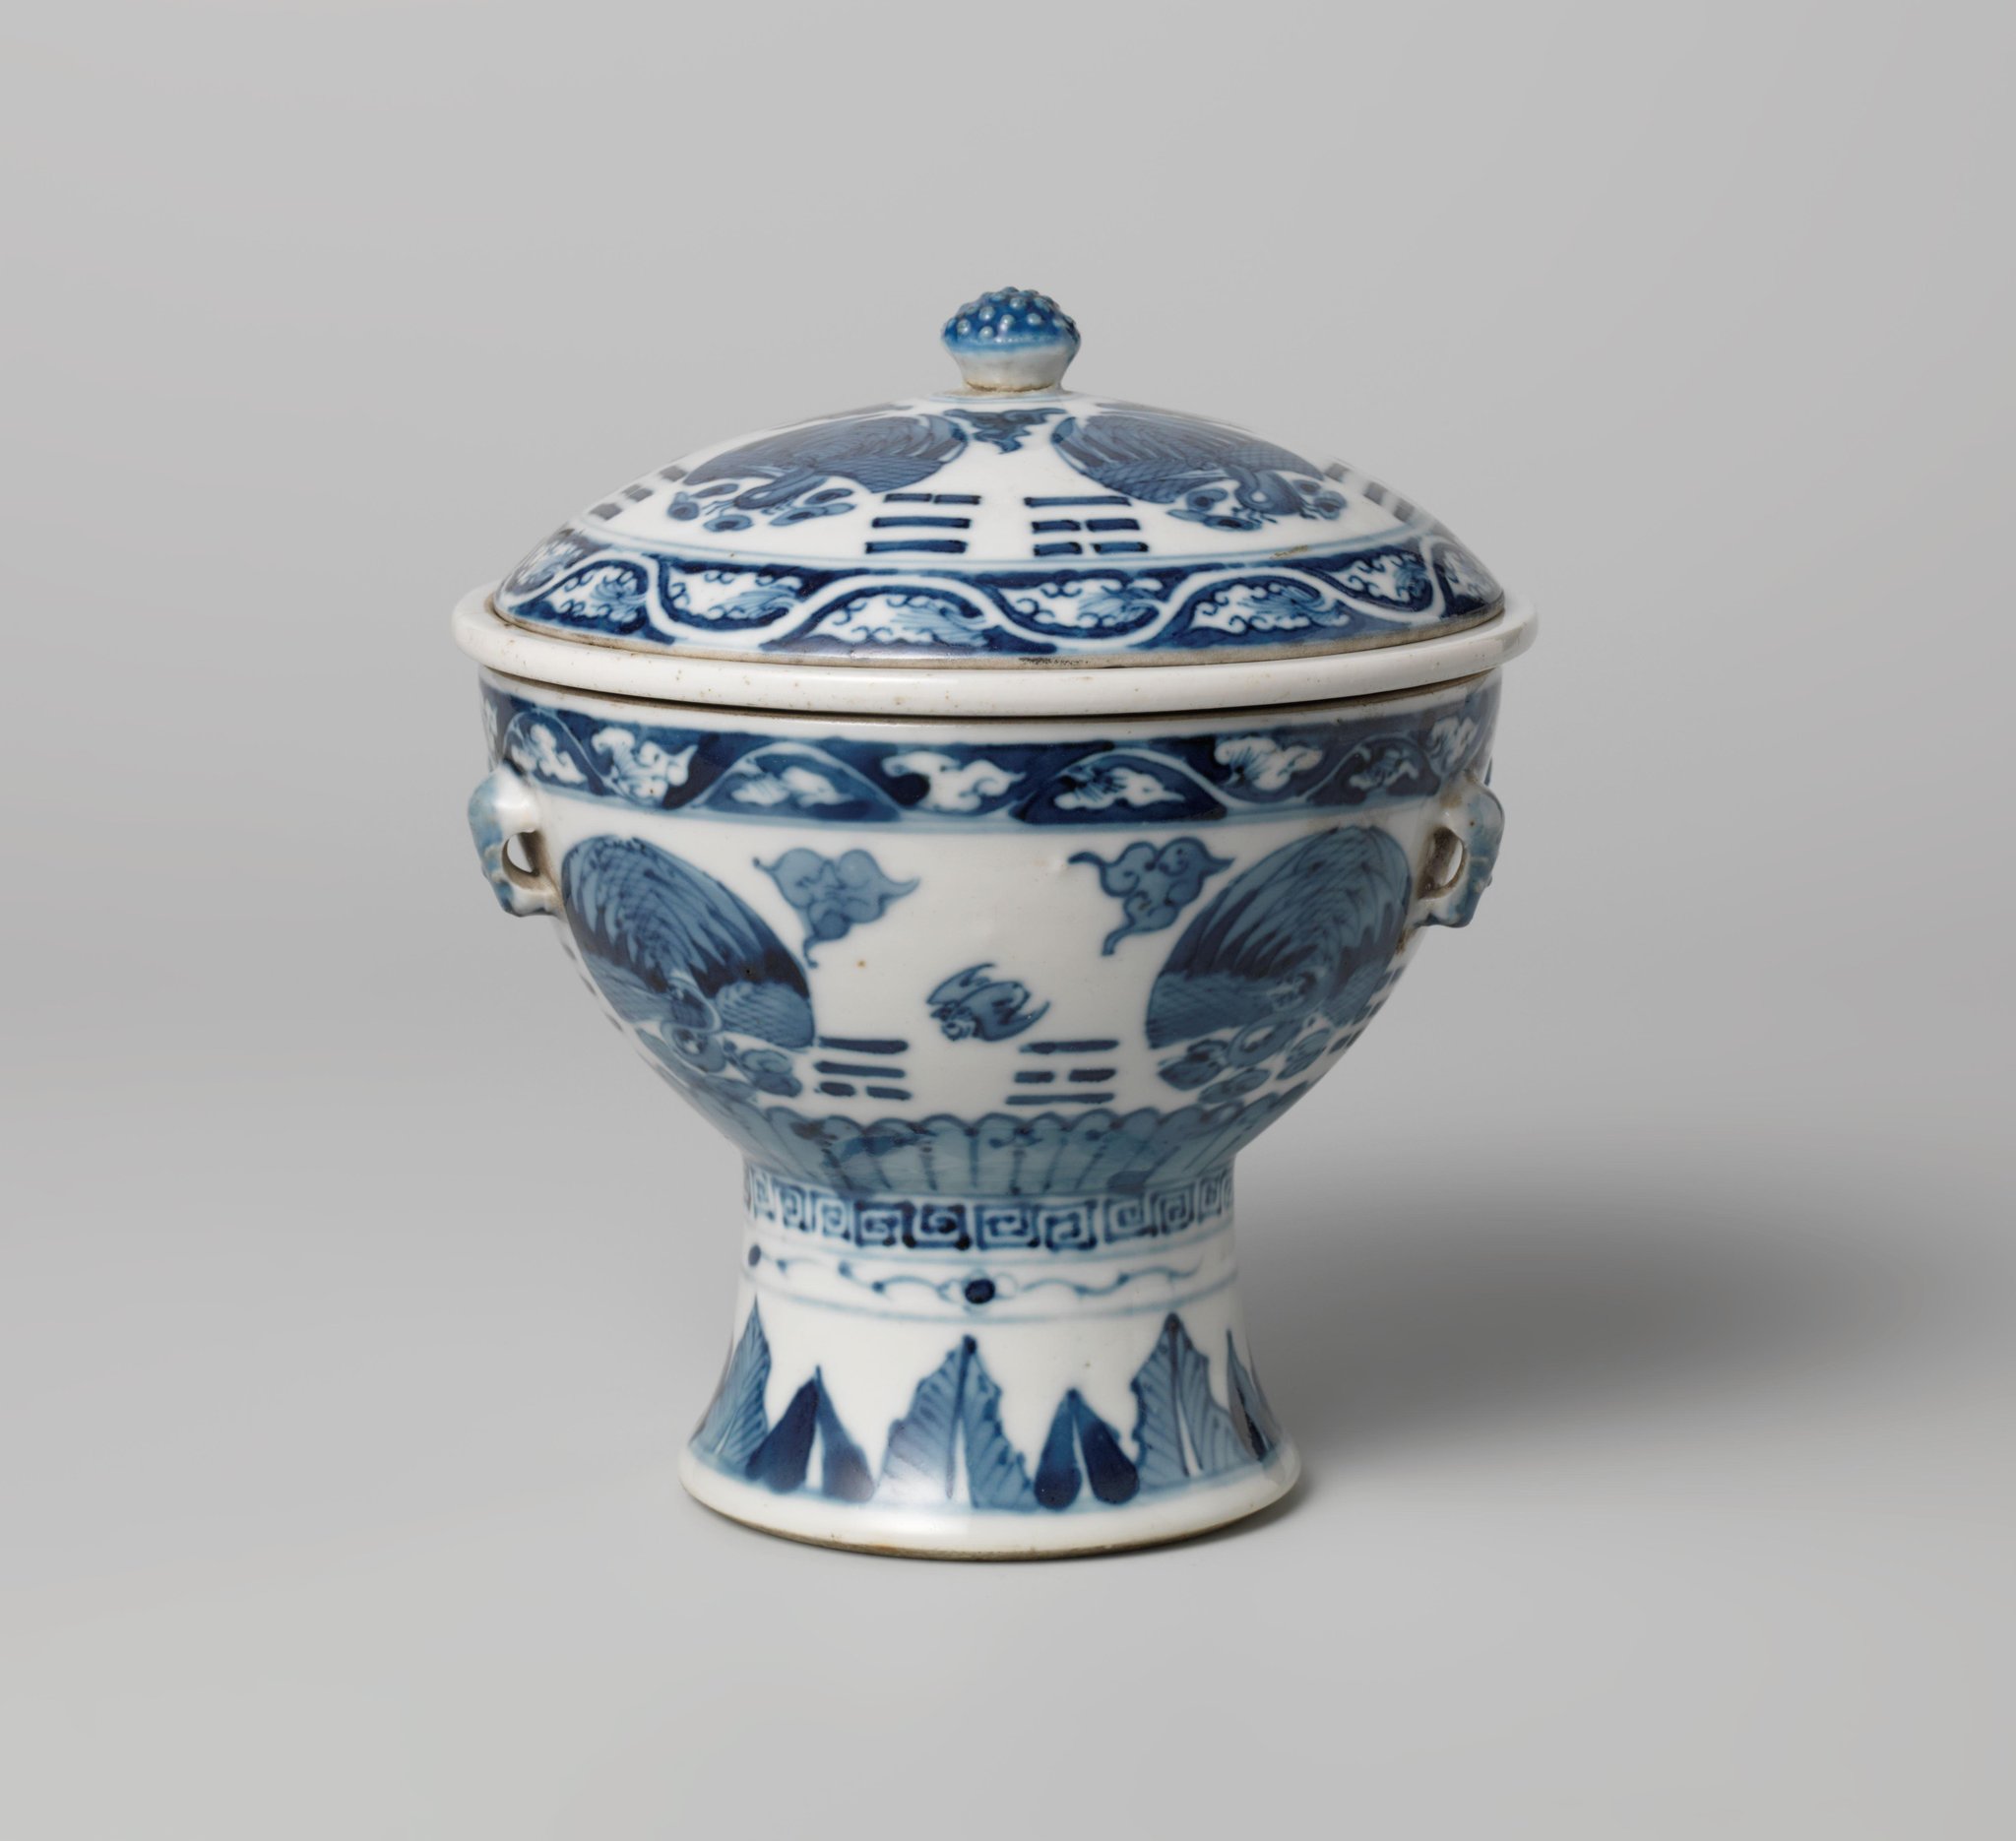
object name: bowl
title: Brazier with crane-shaped medallions and ornamental borders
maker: Anonymous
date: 1675-1724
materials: cobalt, glaze, paint, porcelain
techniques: firing, turning, vitrification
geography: japan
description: Warmhouder, onderglazuur blauw met een feng huang in een cirkel op de wand van de kom, met deksel, op de buitenwand twee oortjes.